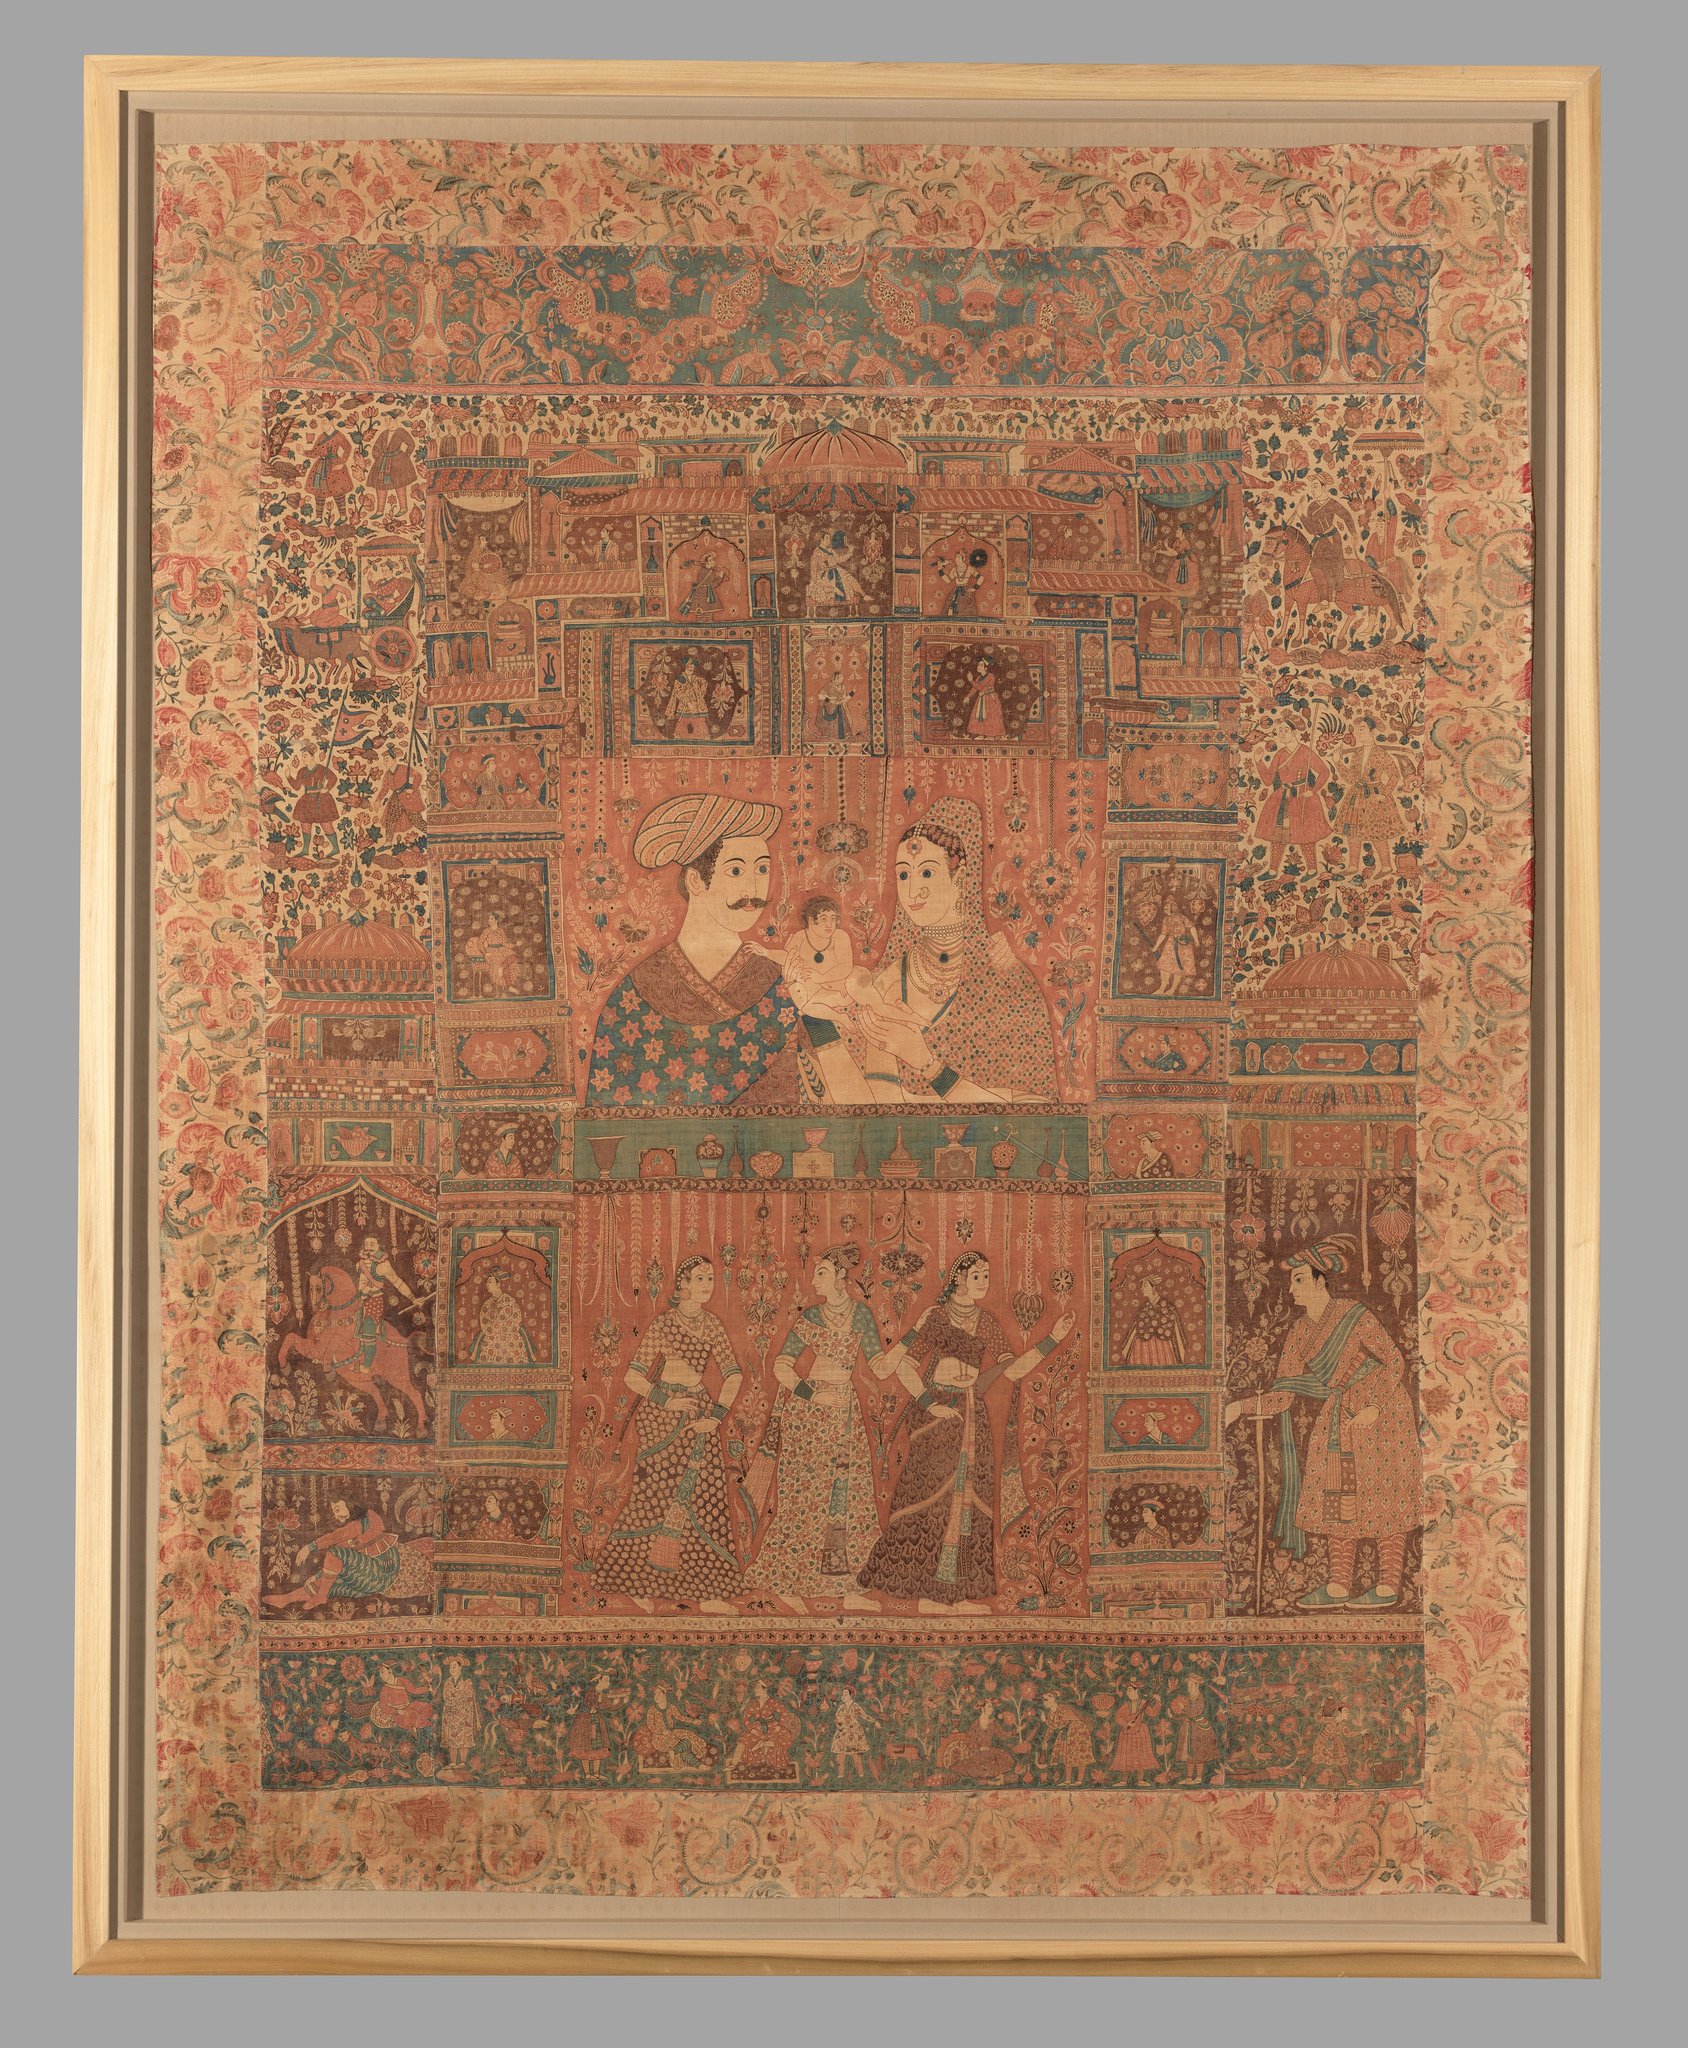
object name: hanging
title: Kalamkari Hanging with Figures in an Architectural Setting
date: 1640-1650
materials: cotton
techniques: dyeing, painting, weave, resist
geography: india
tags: men,women,horses,flowers